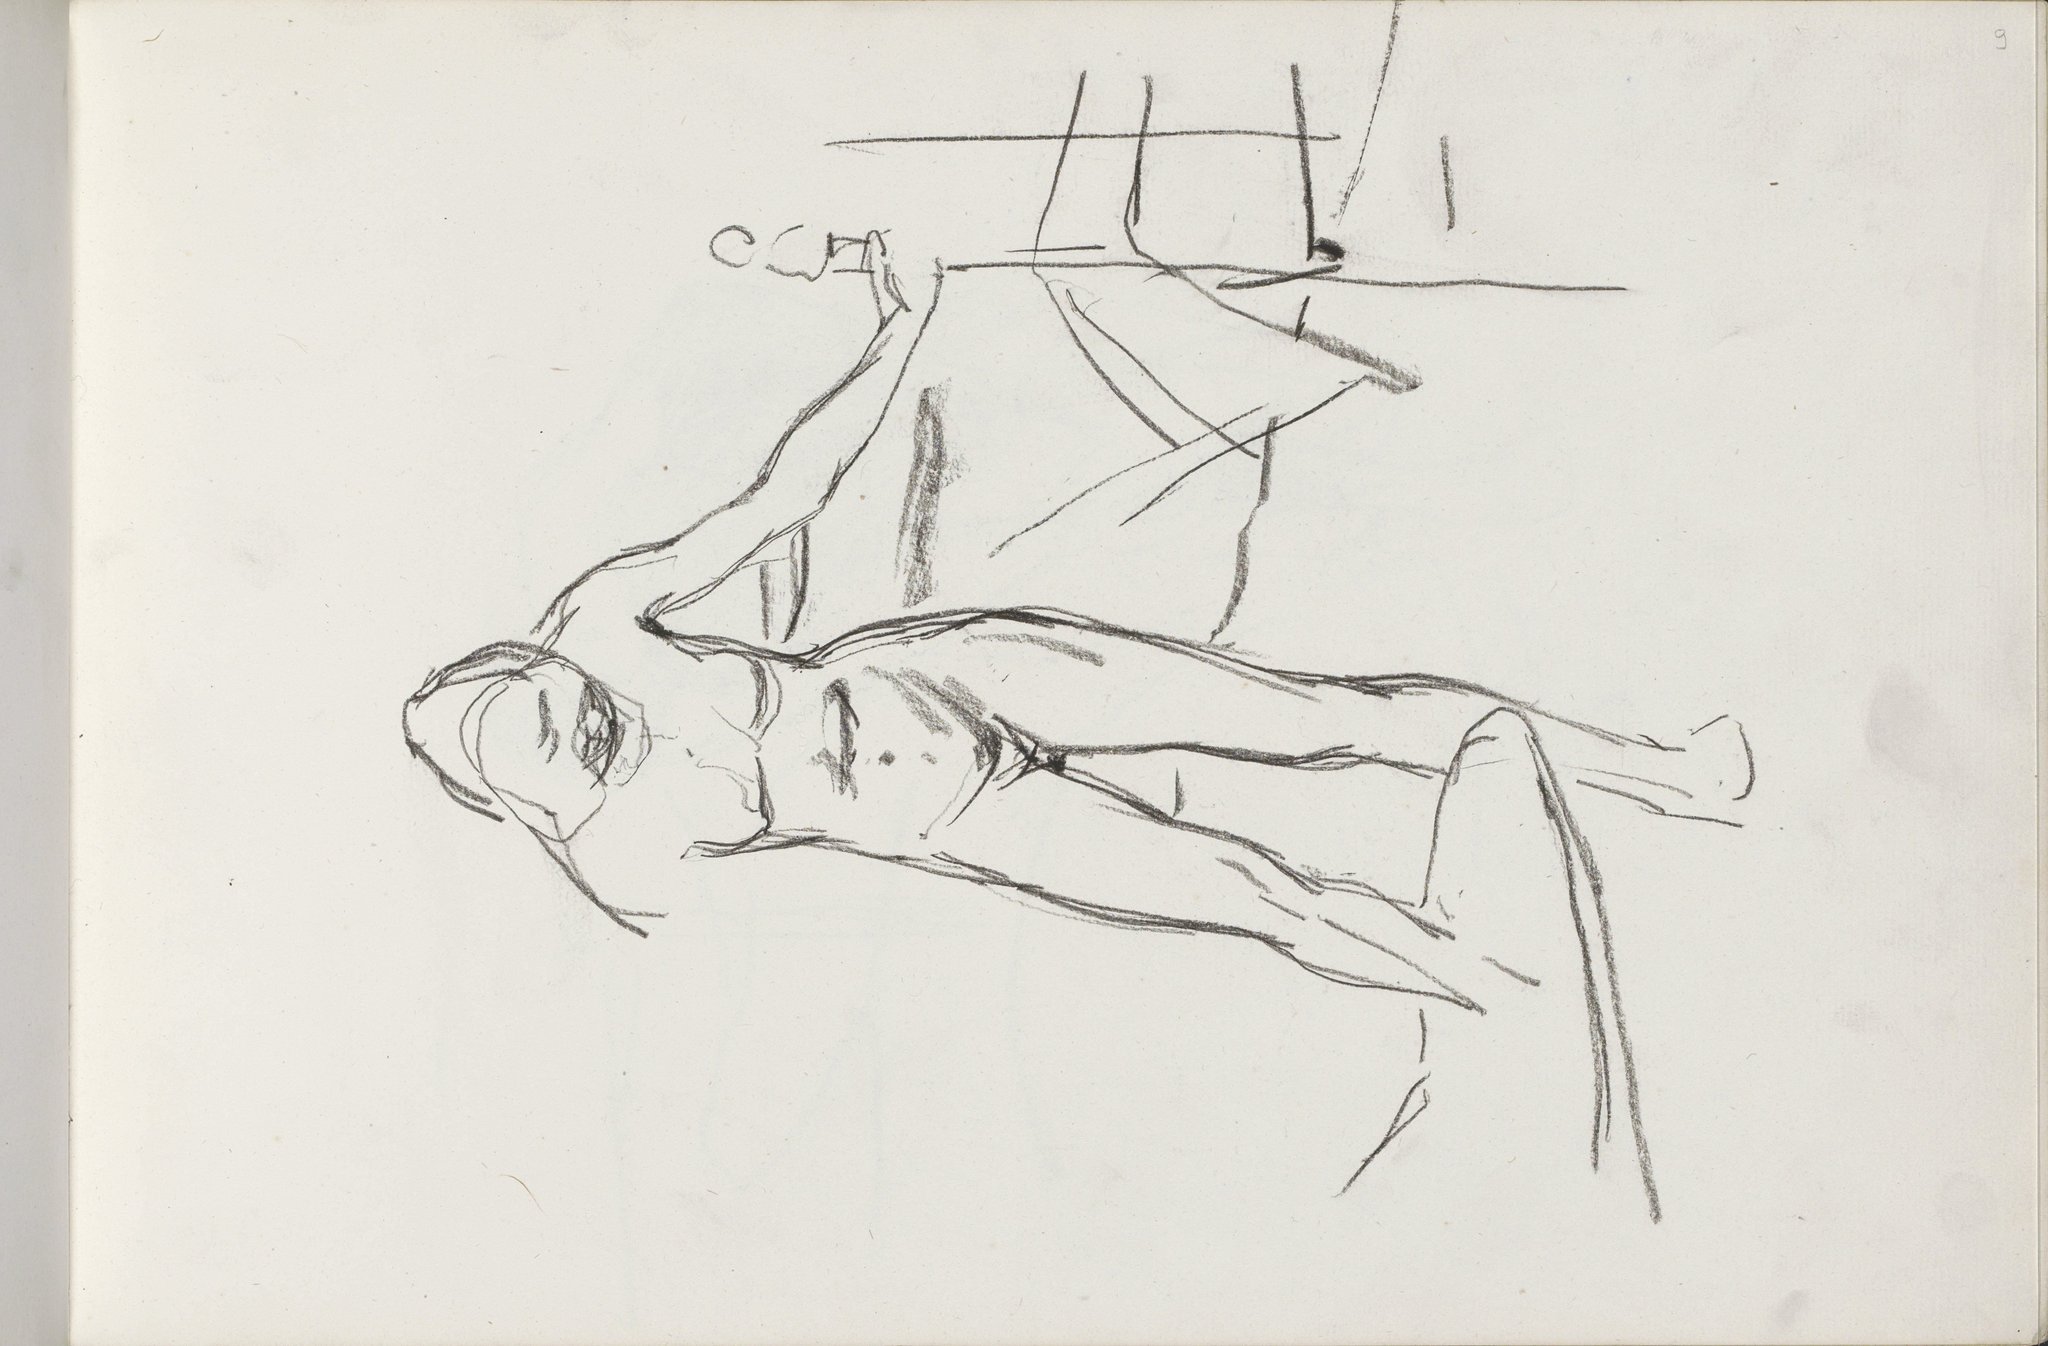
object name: sketchbook leaf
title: Vrouwelijk naakt naast een bed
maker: willem witsen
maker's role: draughtsman, painter, print maker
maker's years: 1860-1923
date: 1887-1892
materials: chalk, paper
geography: amsterdam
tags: the (nude) human figure; 'corpo humano' (ripa) - aa - female human figure (+ standing), bed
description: De vrouw staat en houdt een bedspijl vast. Ze stapt mogelijk in een bad of tobbe. Pagina 9 uit een schetsboek met 17 bladen.